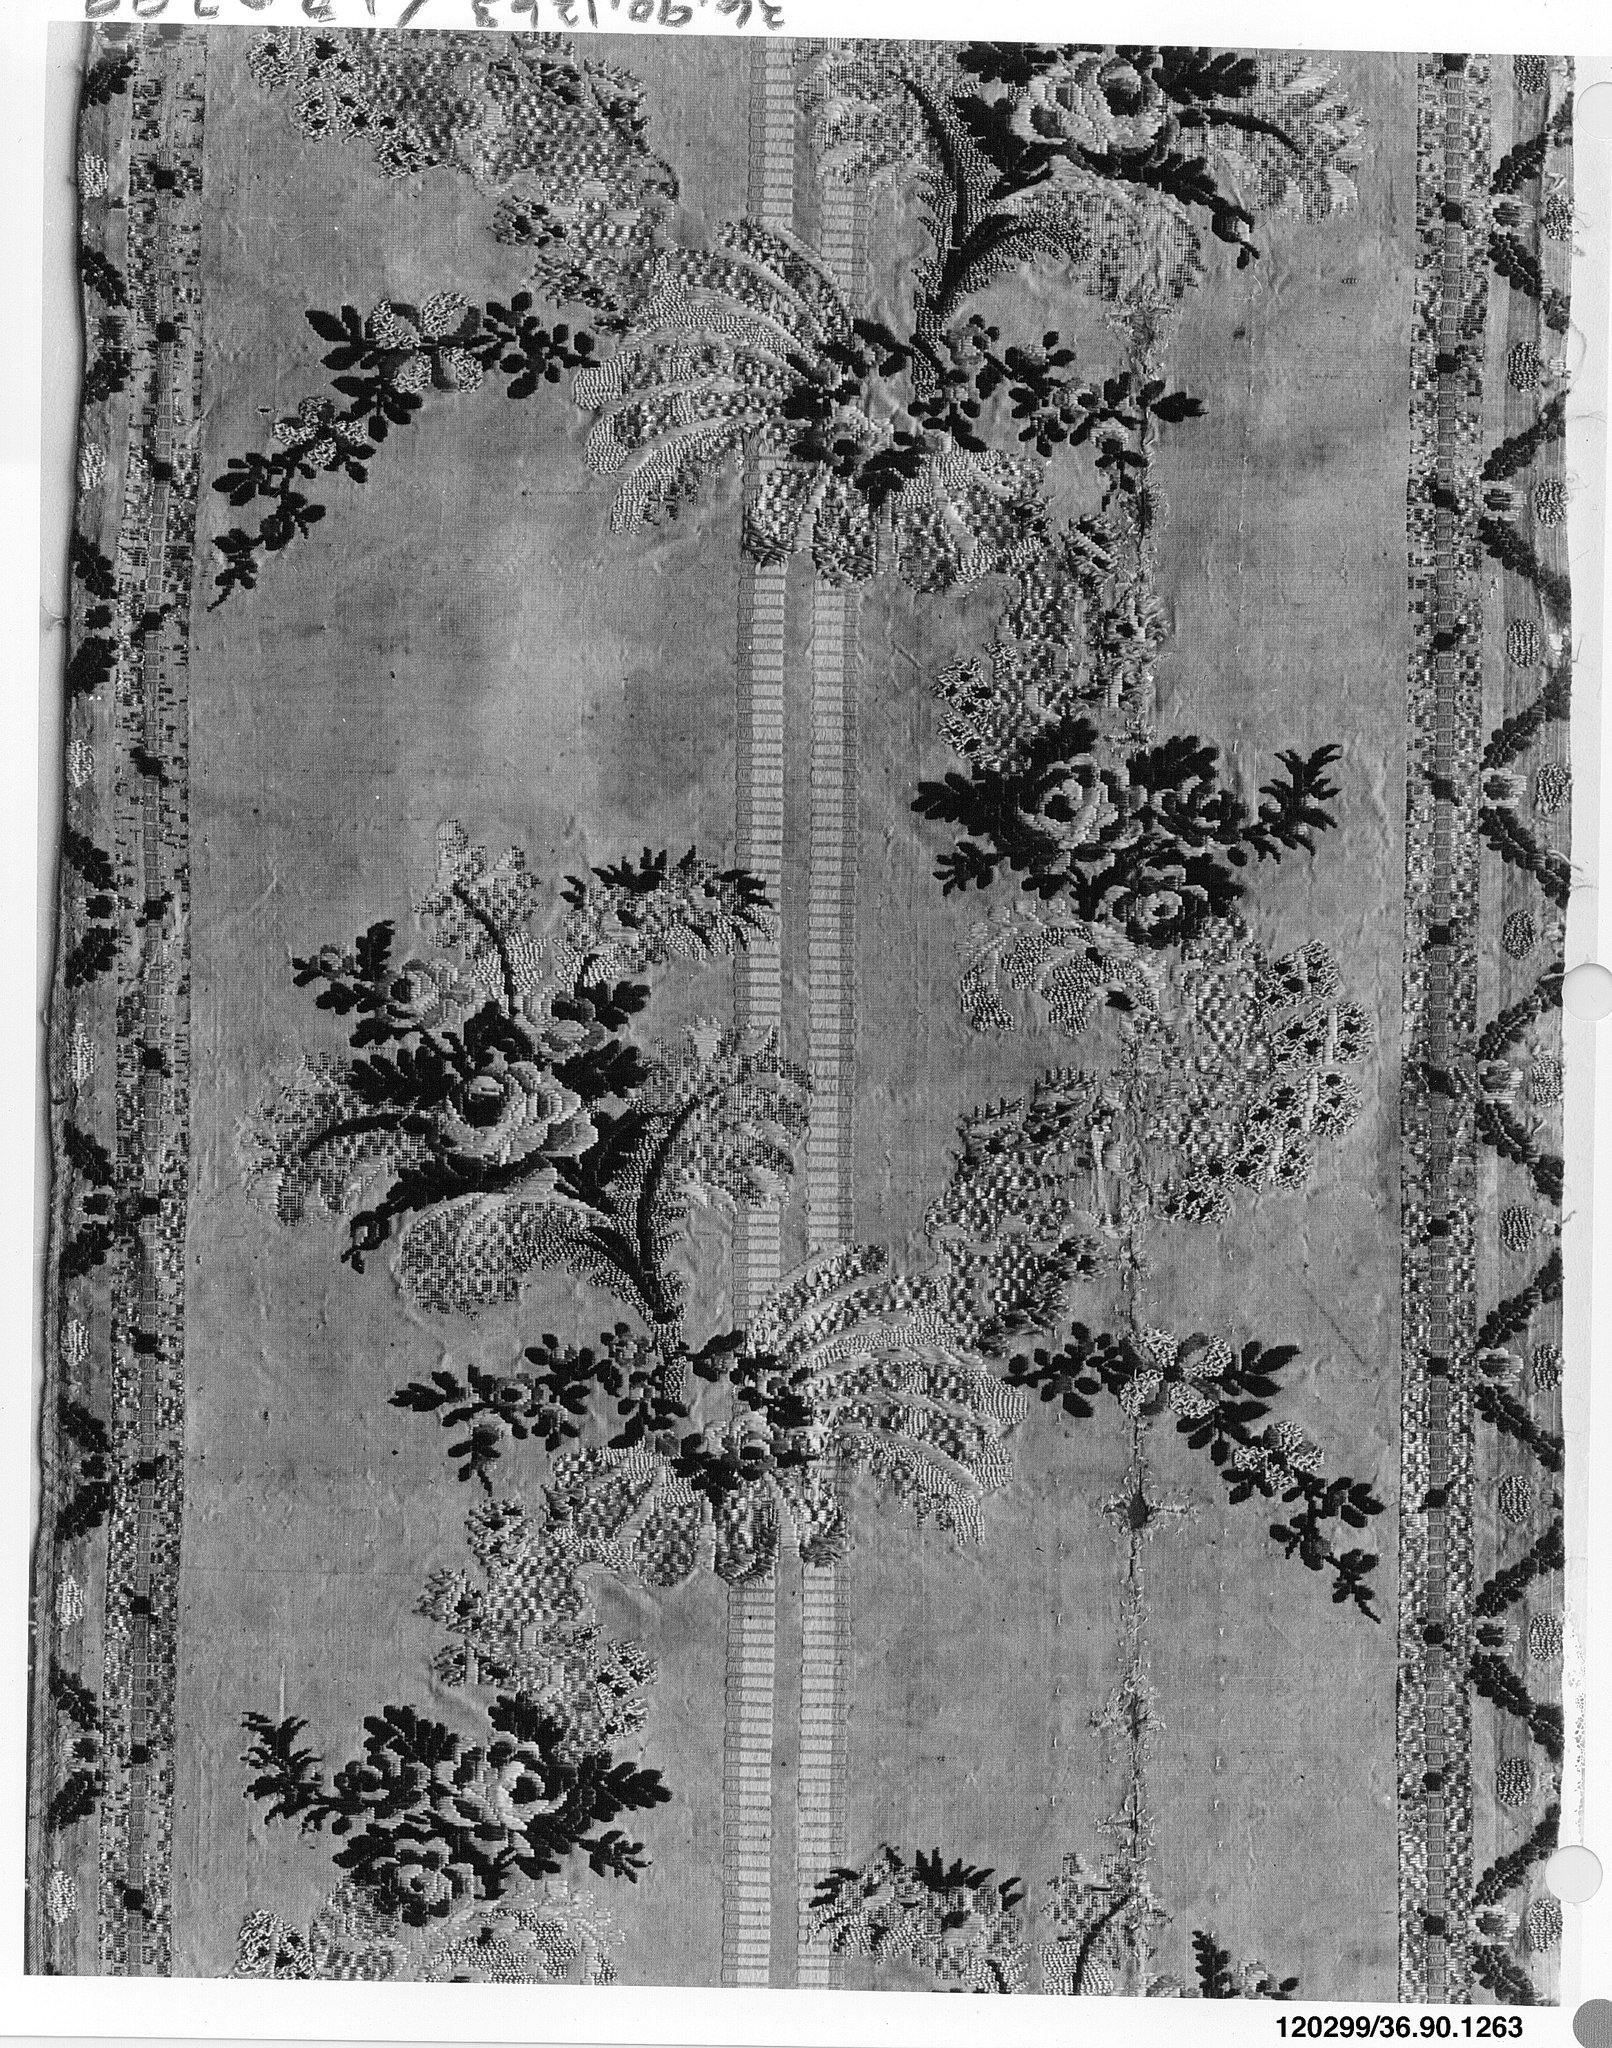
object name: piece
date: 1760-1770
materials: metal thread, silk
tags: flowers,leaves